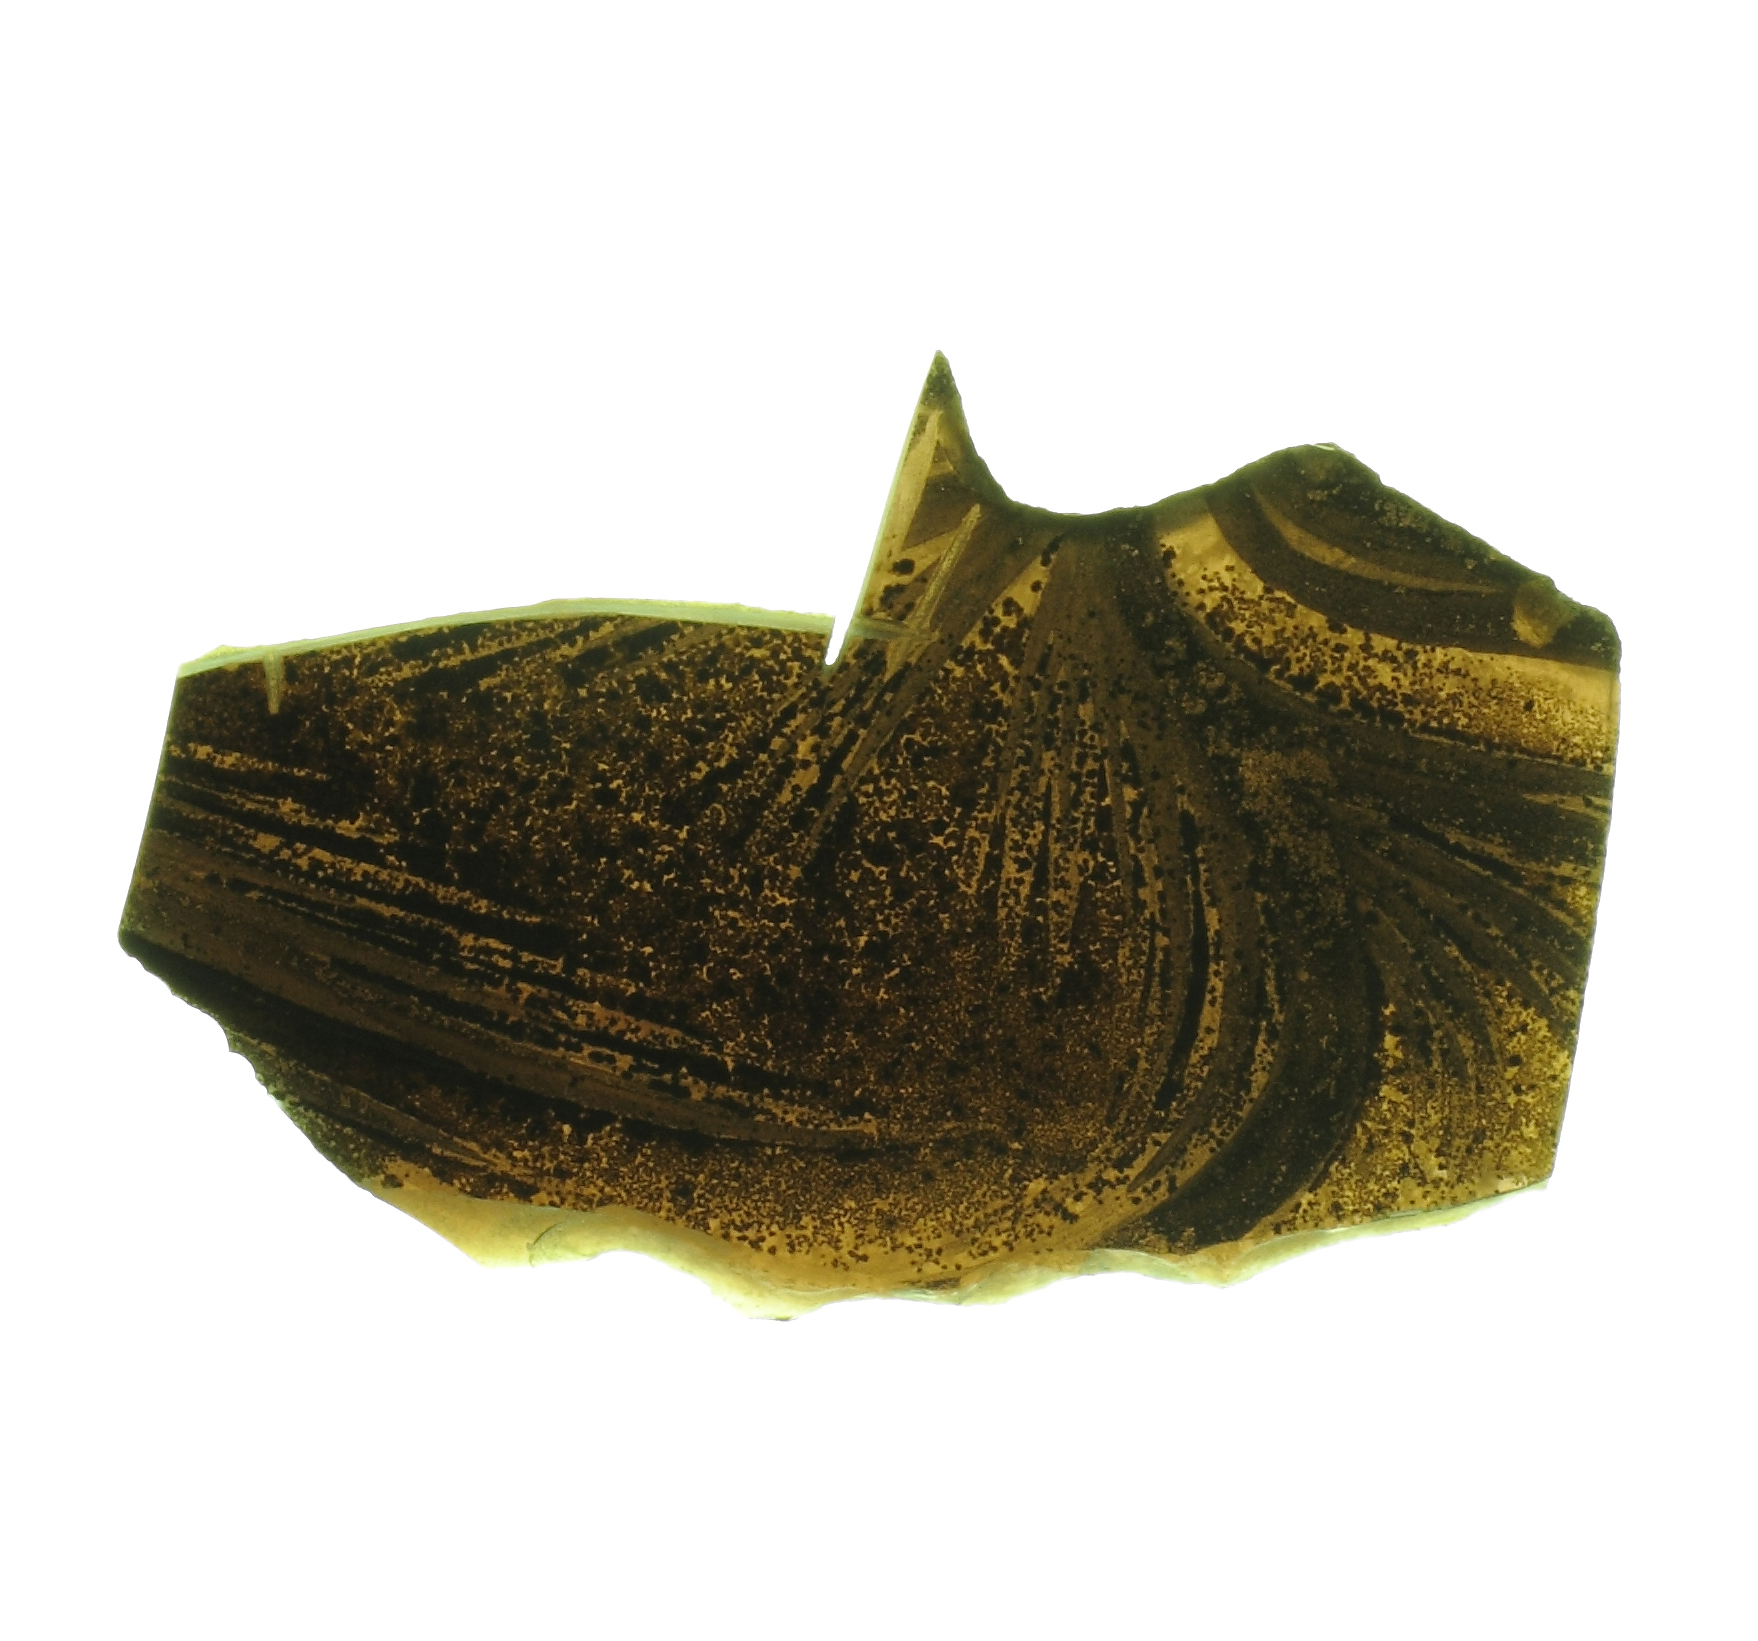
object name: fragment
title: Glass Fragment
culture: french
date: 1101-1400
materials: glass, metal, paint